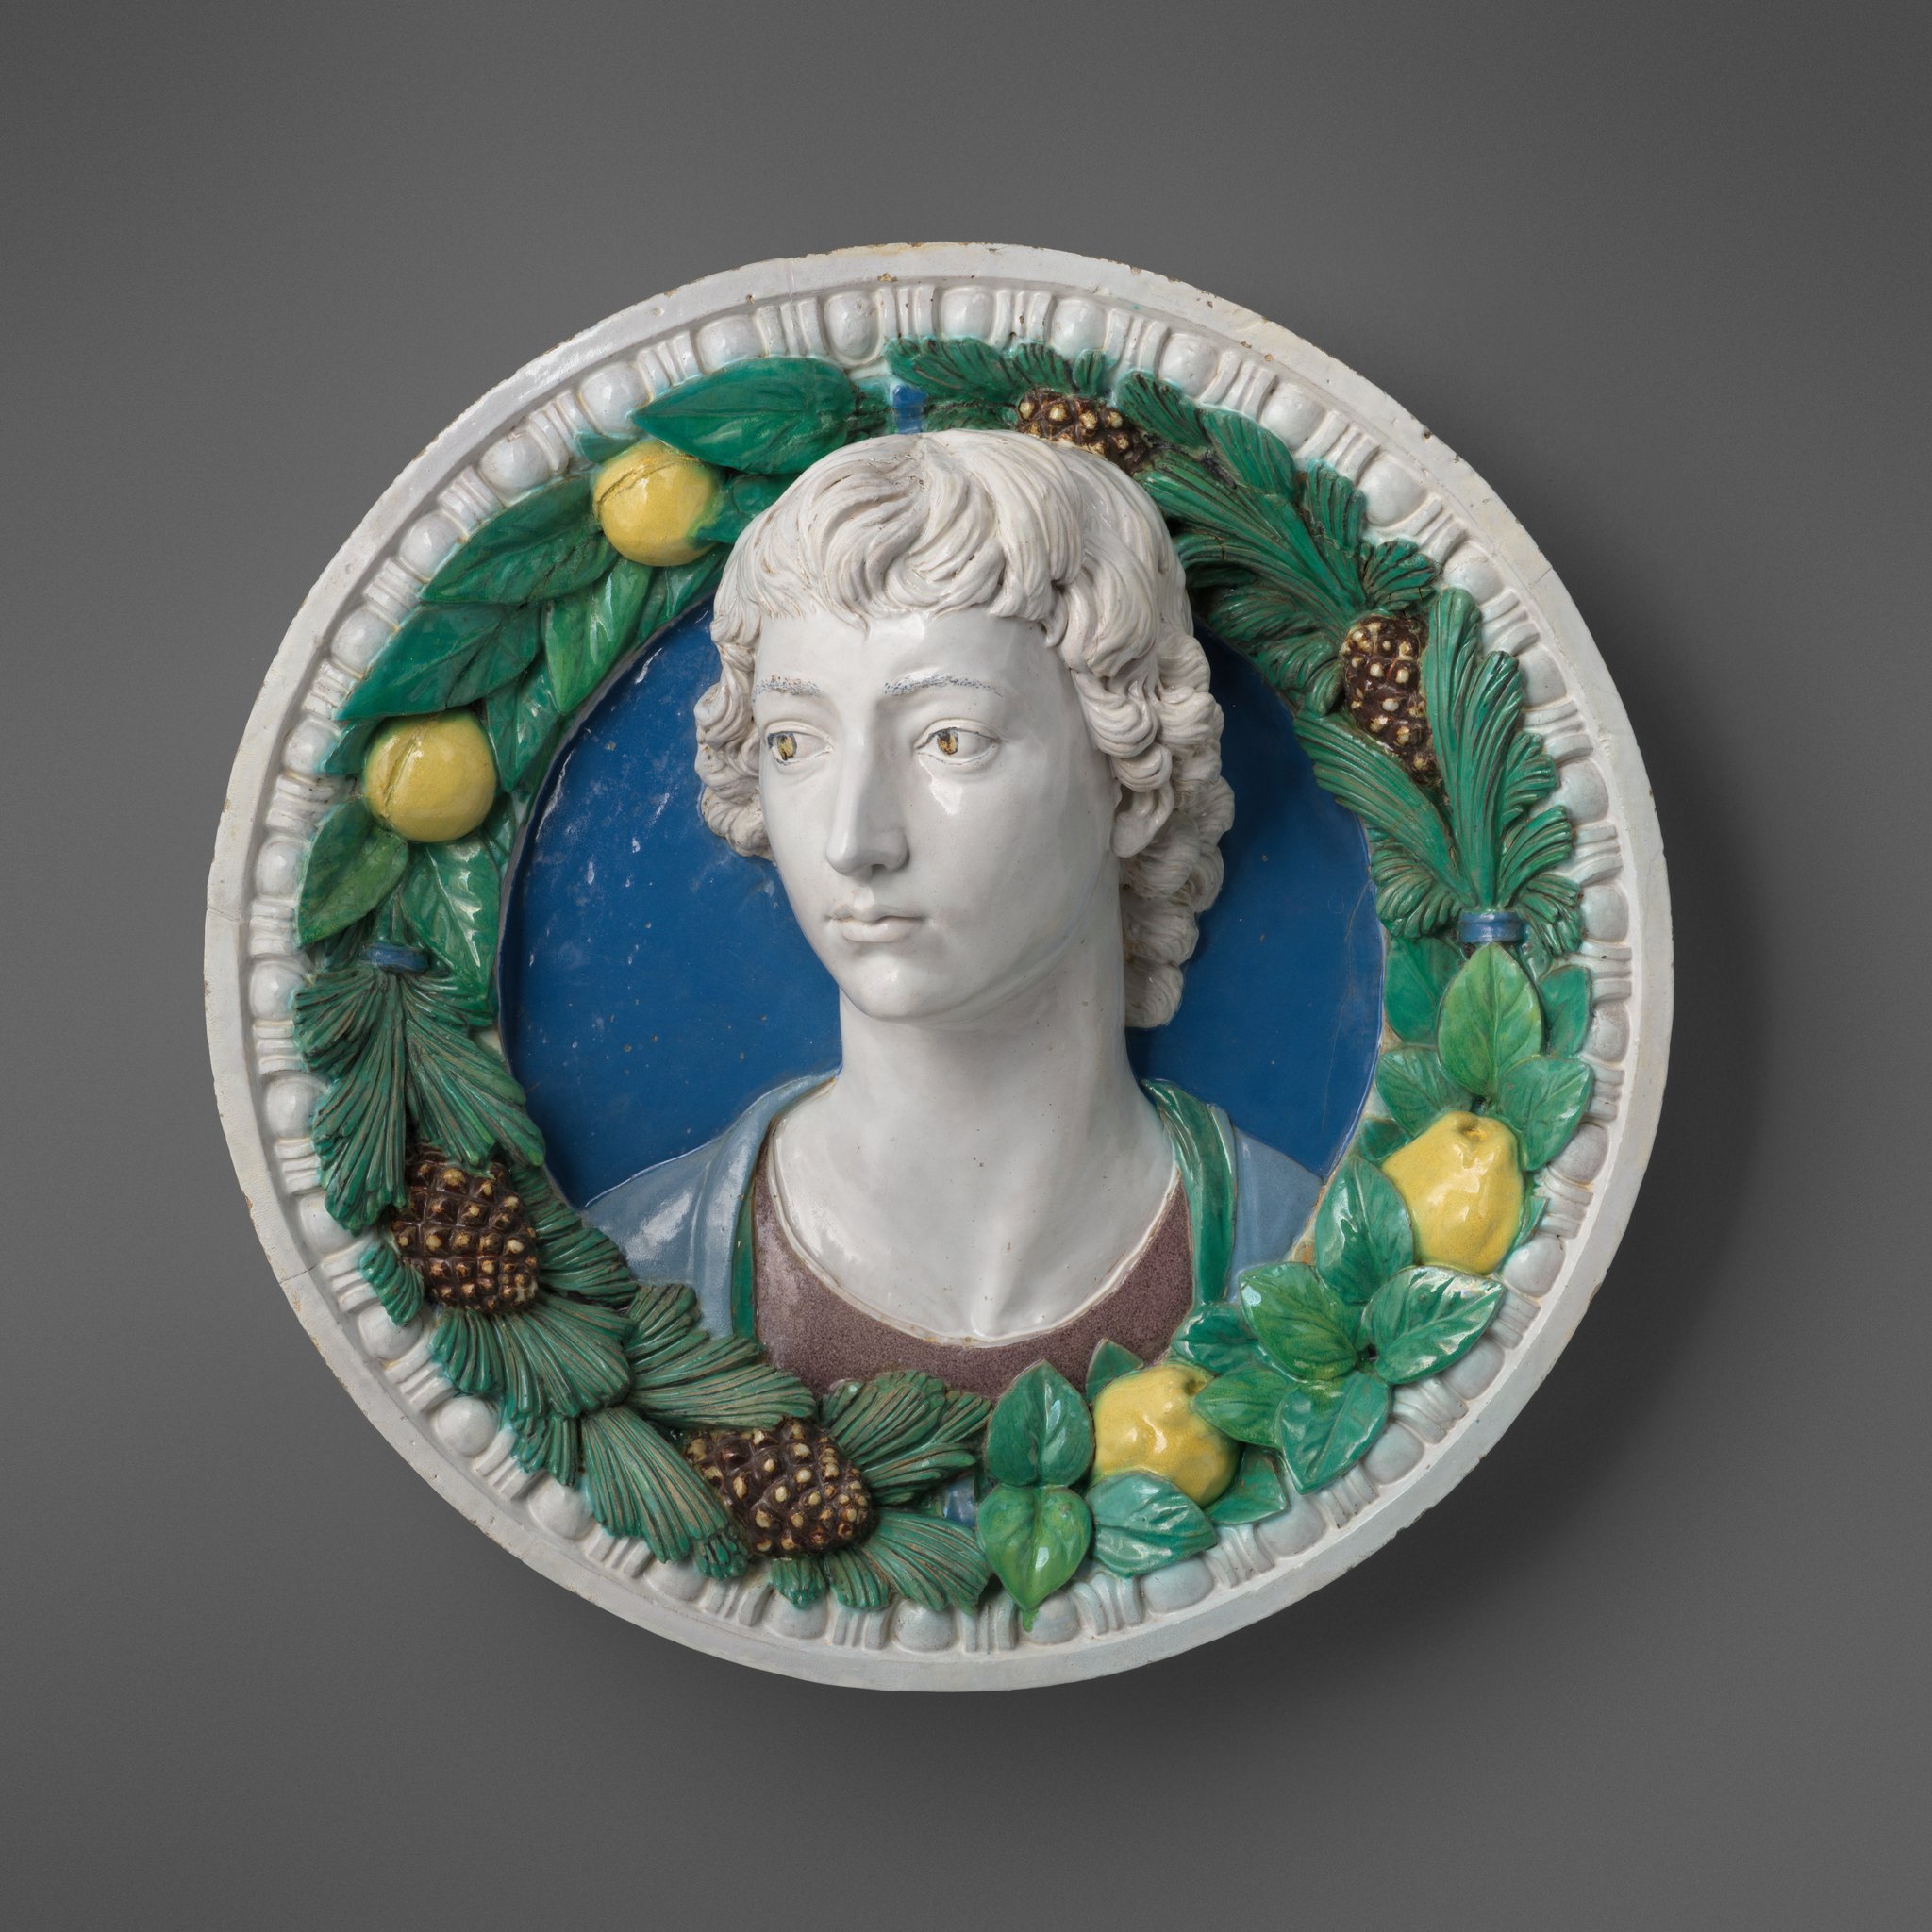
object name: medallion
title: Head of a youth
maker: andrea della robbia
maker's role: artist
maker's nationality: italian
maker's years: 1435-1525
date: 1470-1479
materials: terracotta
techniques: glazing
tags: fruit,heads